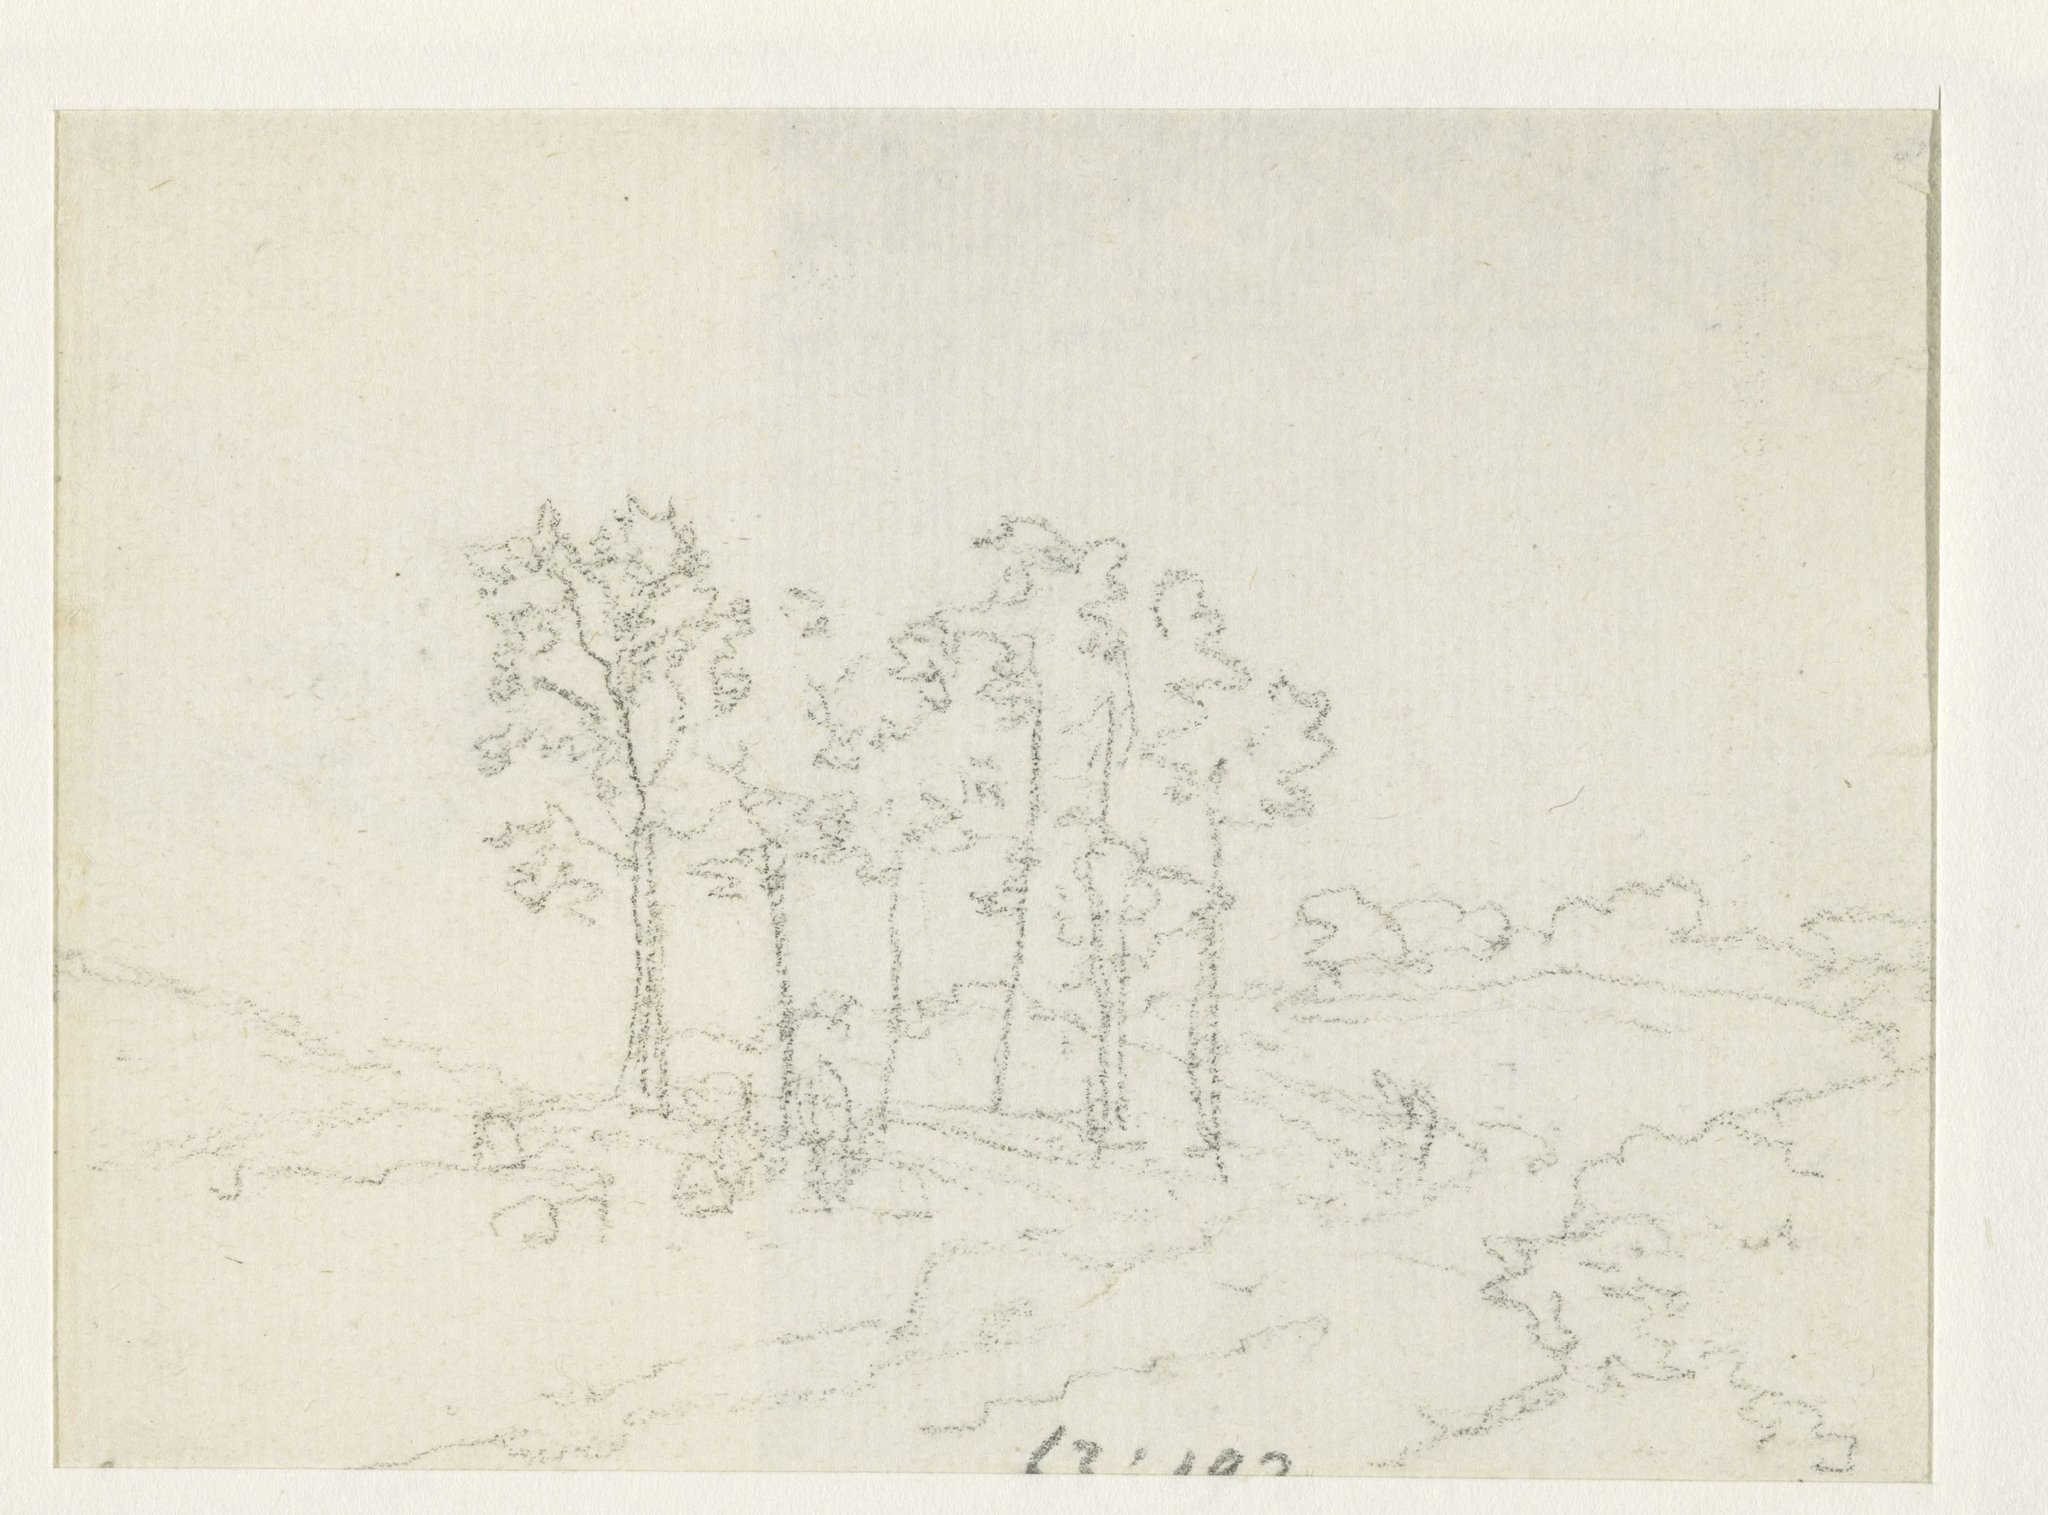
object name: drawing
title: Schetsje van een boomgroep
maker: georges michel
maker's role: draughtsman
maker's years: 1763-1843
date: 1773-1843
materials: paper, pencil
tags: groups of trees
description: Een van 120 tekeningen, afkomstig uit een 19e eeuws album met tekeningen van Georges Michel.